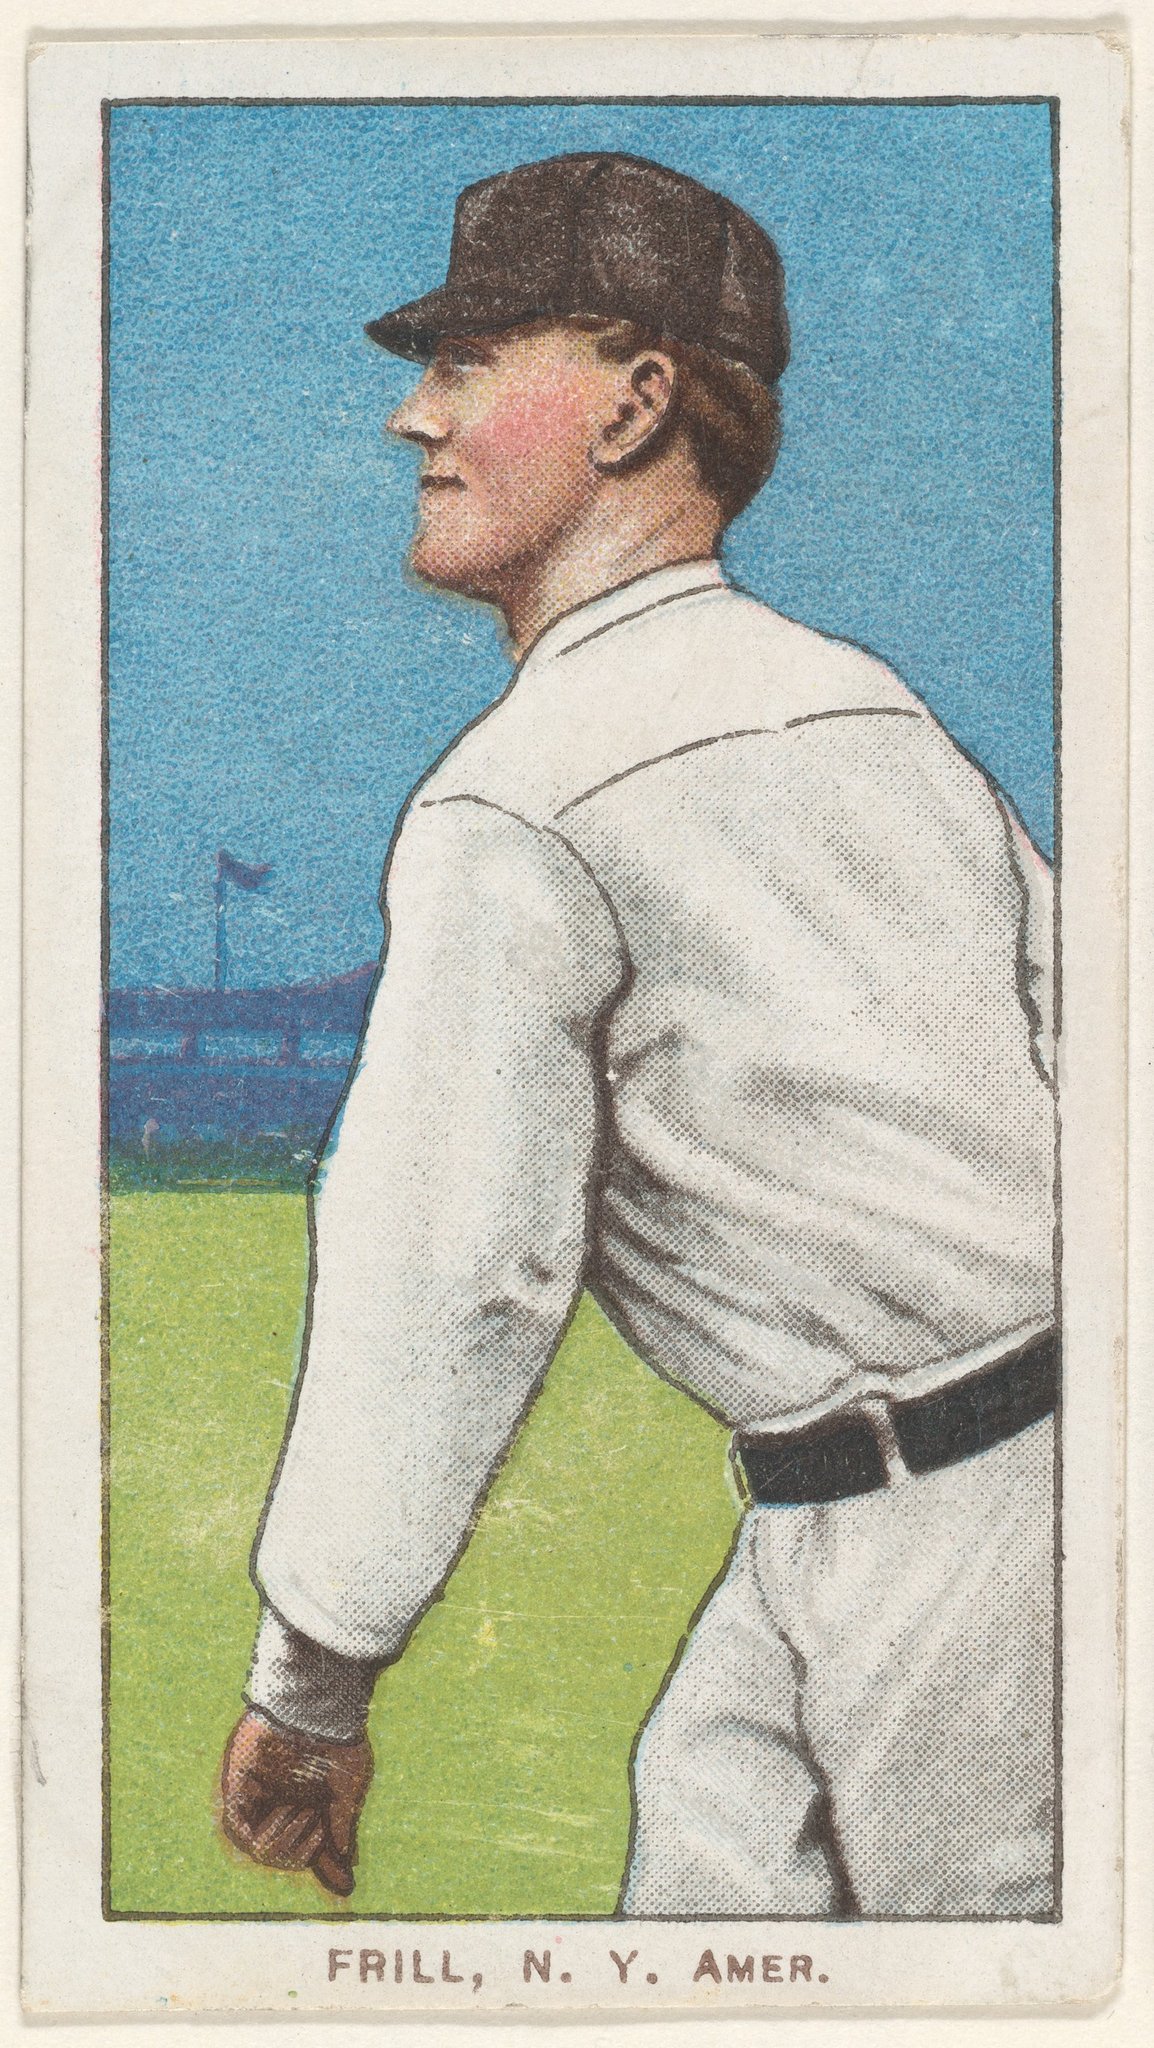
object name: baseball card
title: Frill, New York, American League, from the White Border series (T206) for the American Tobacco Company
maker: american tobacco company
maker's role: publisher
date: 1909-1911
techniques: lithography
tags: men,baseball,athletes